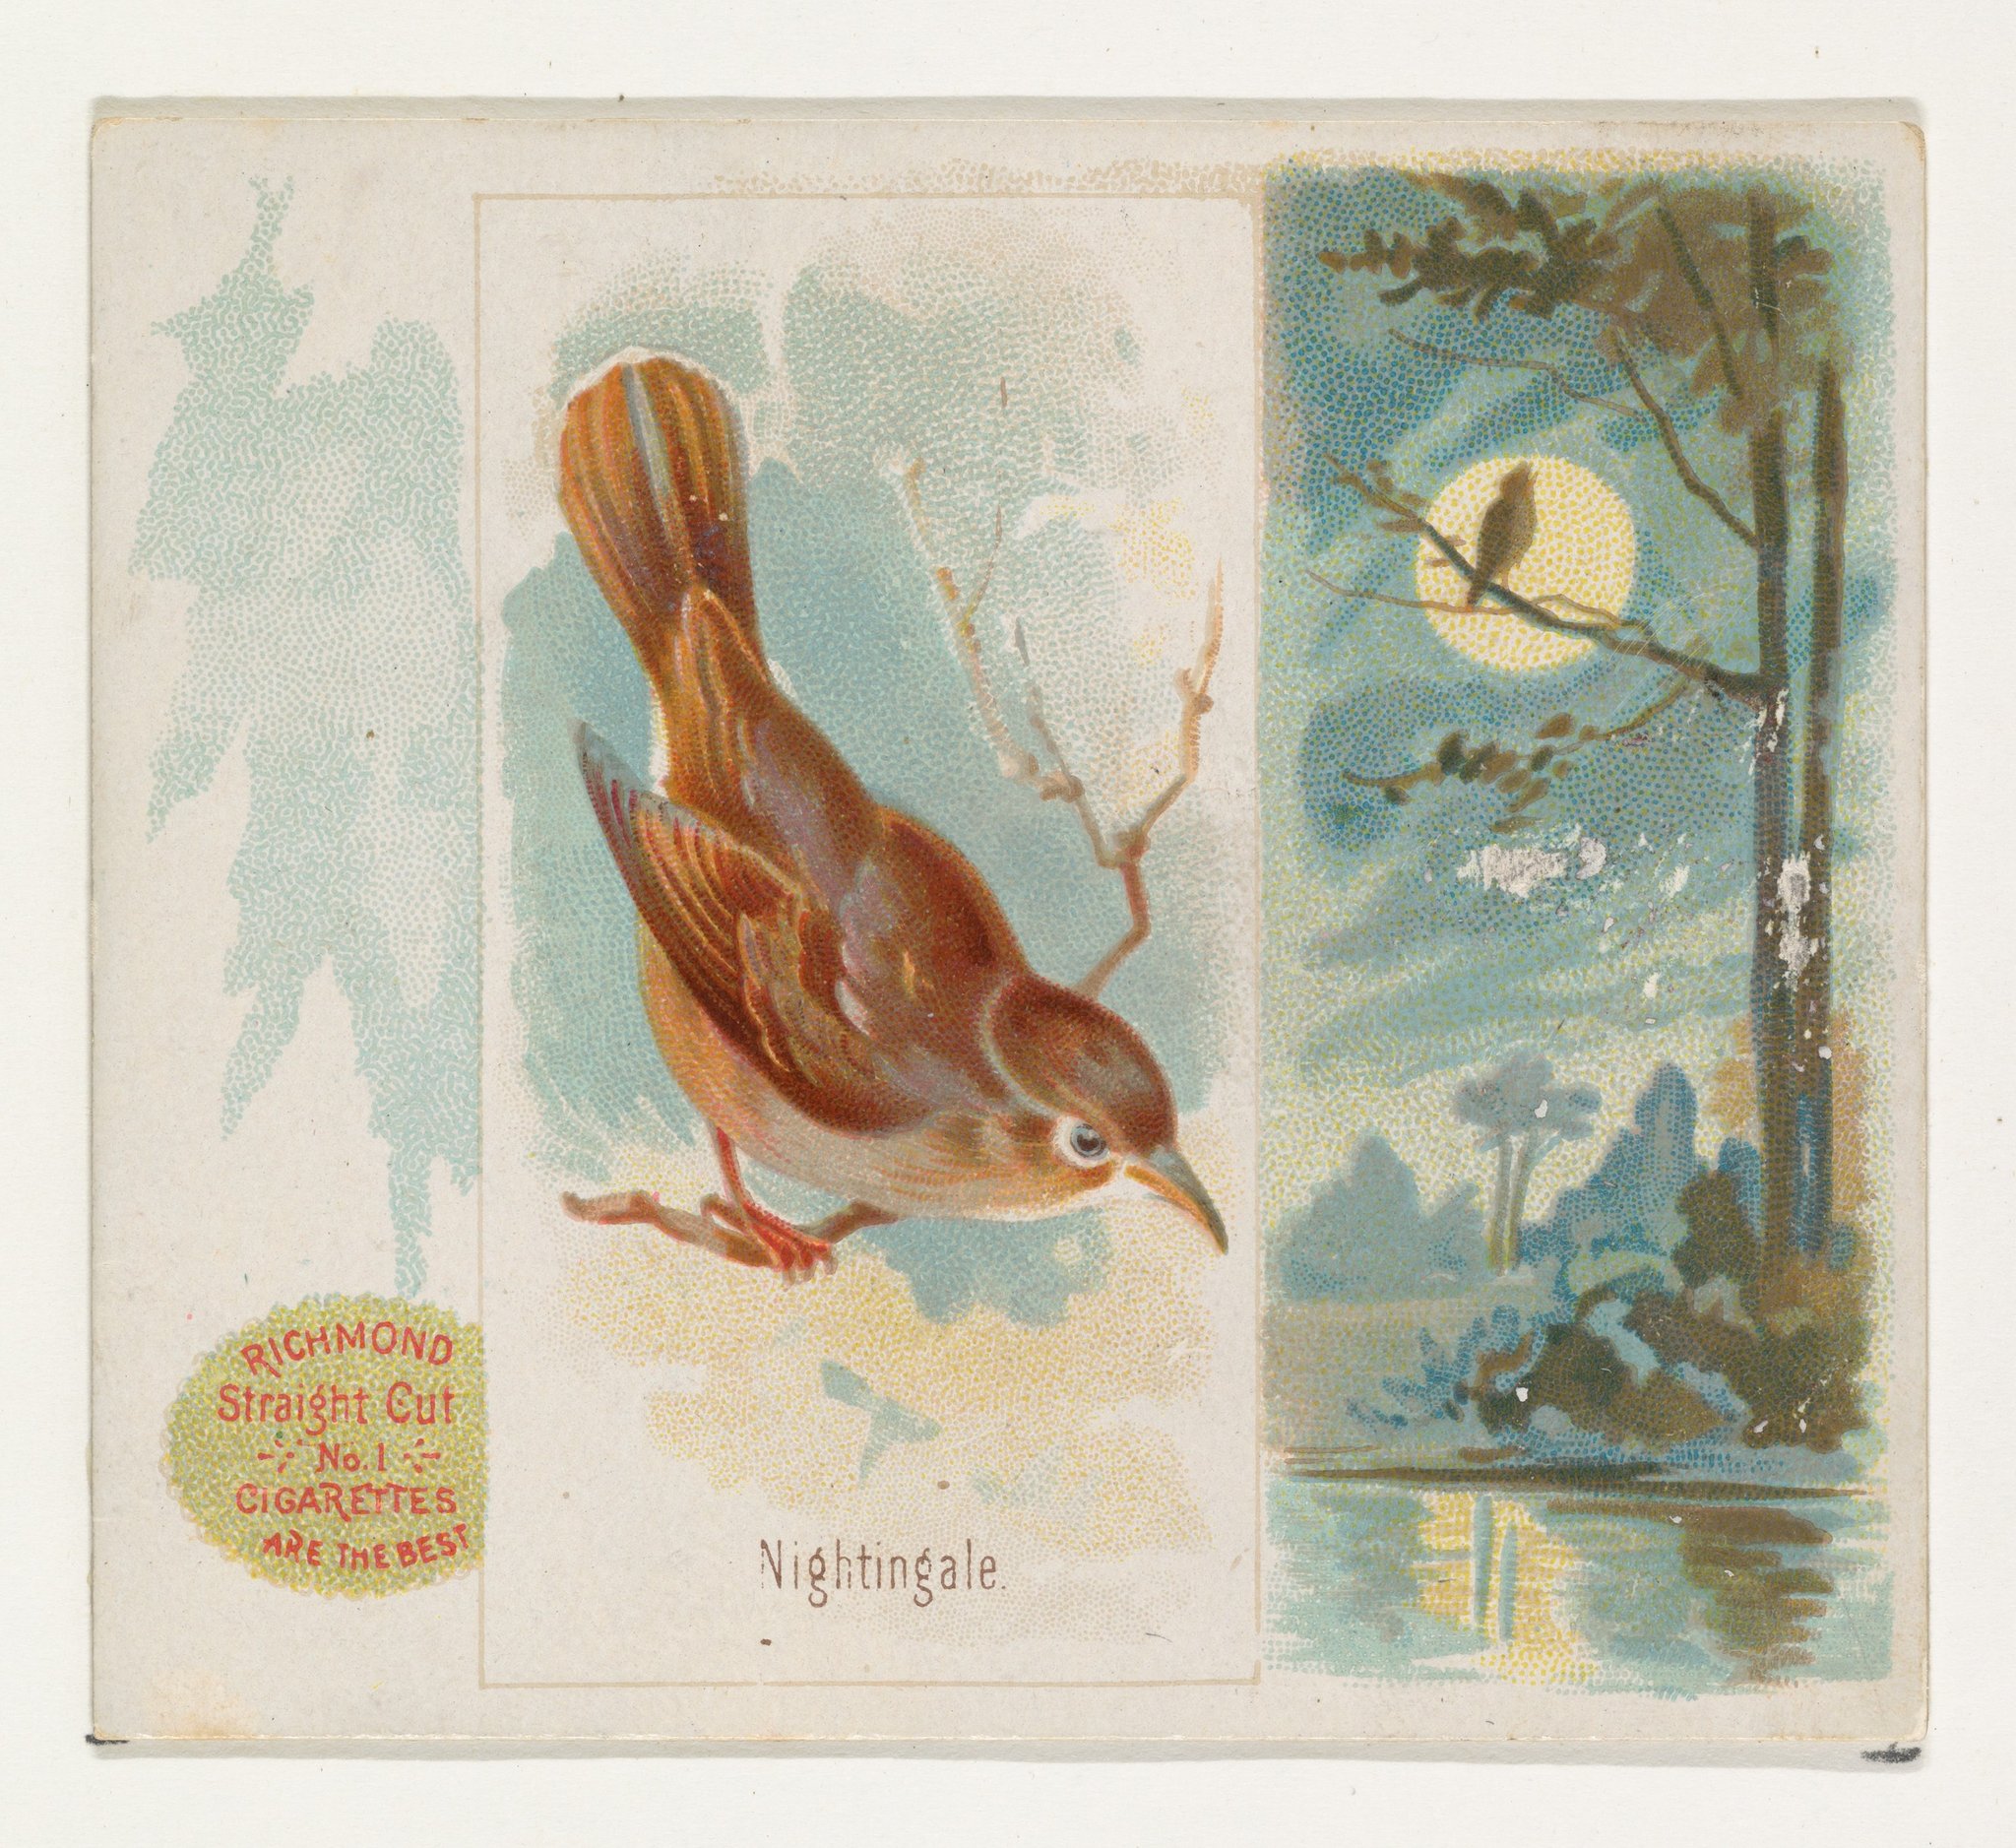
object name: print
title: Nightingale, from the Song Birds of the World series (N42) for Allen & Ginter Cigarettes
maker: allen & ginter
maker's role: publisher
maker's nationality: american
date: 1890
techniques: color lithograph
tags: birds